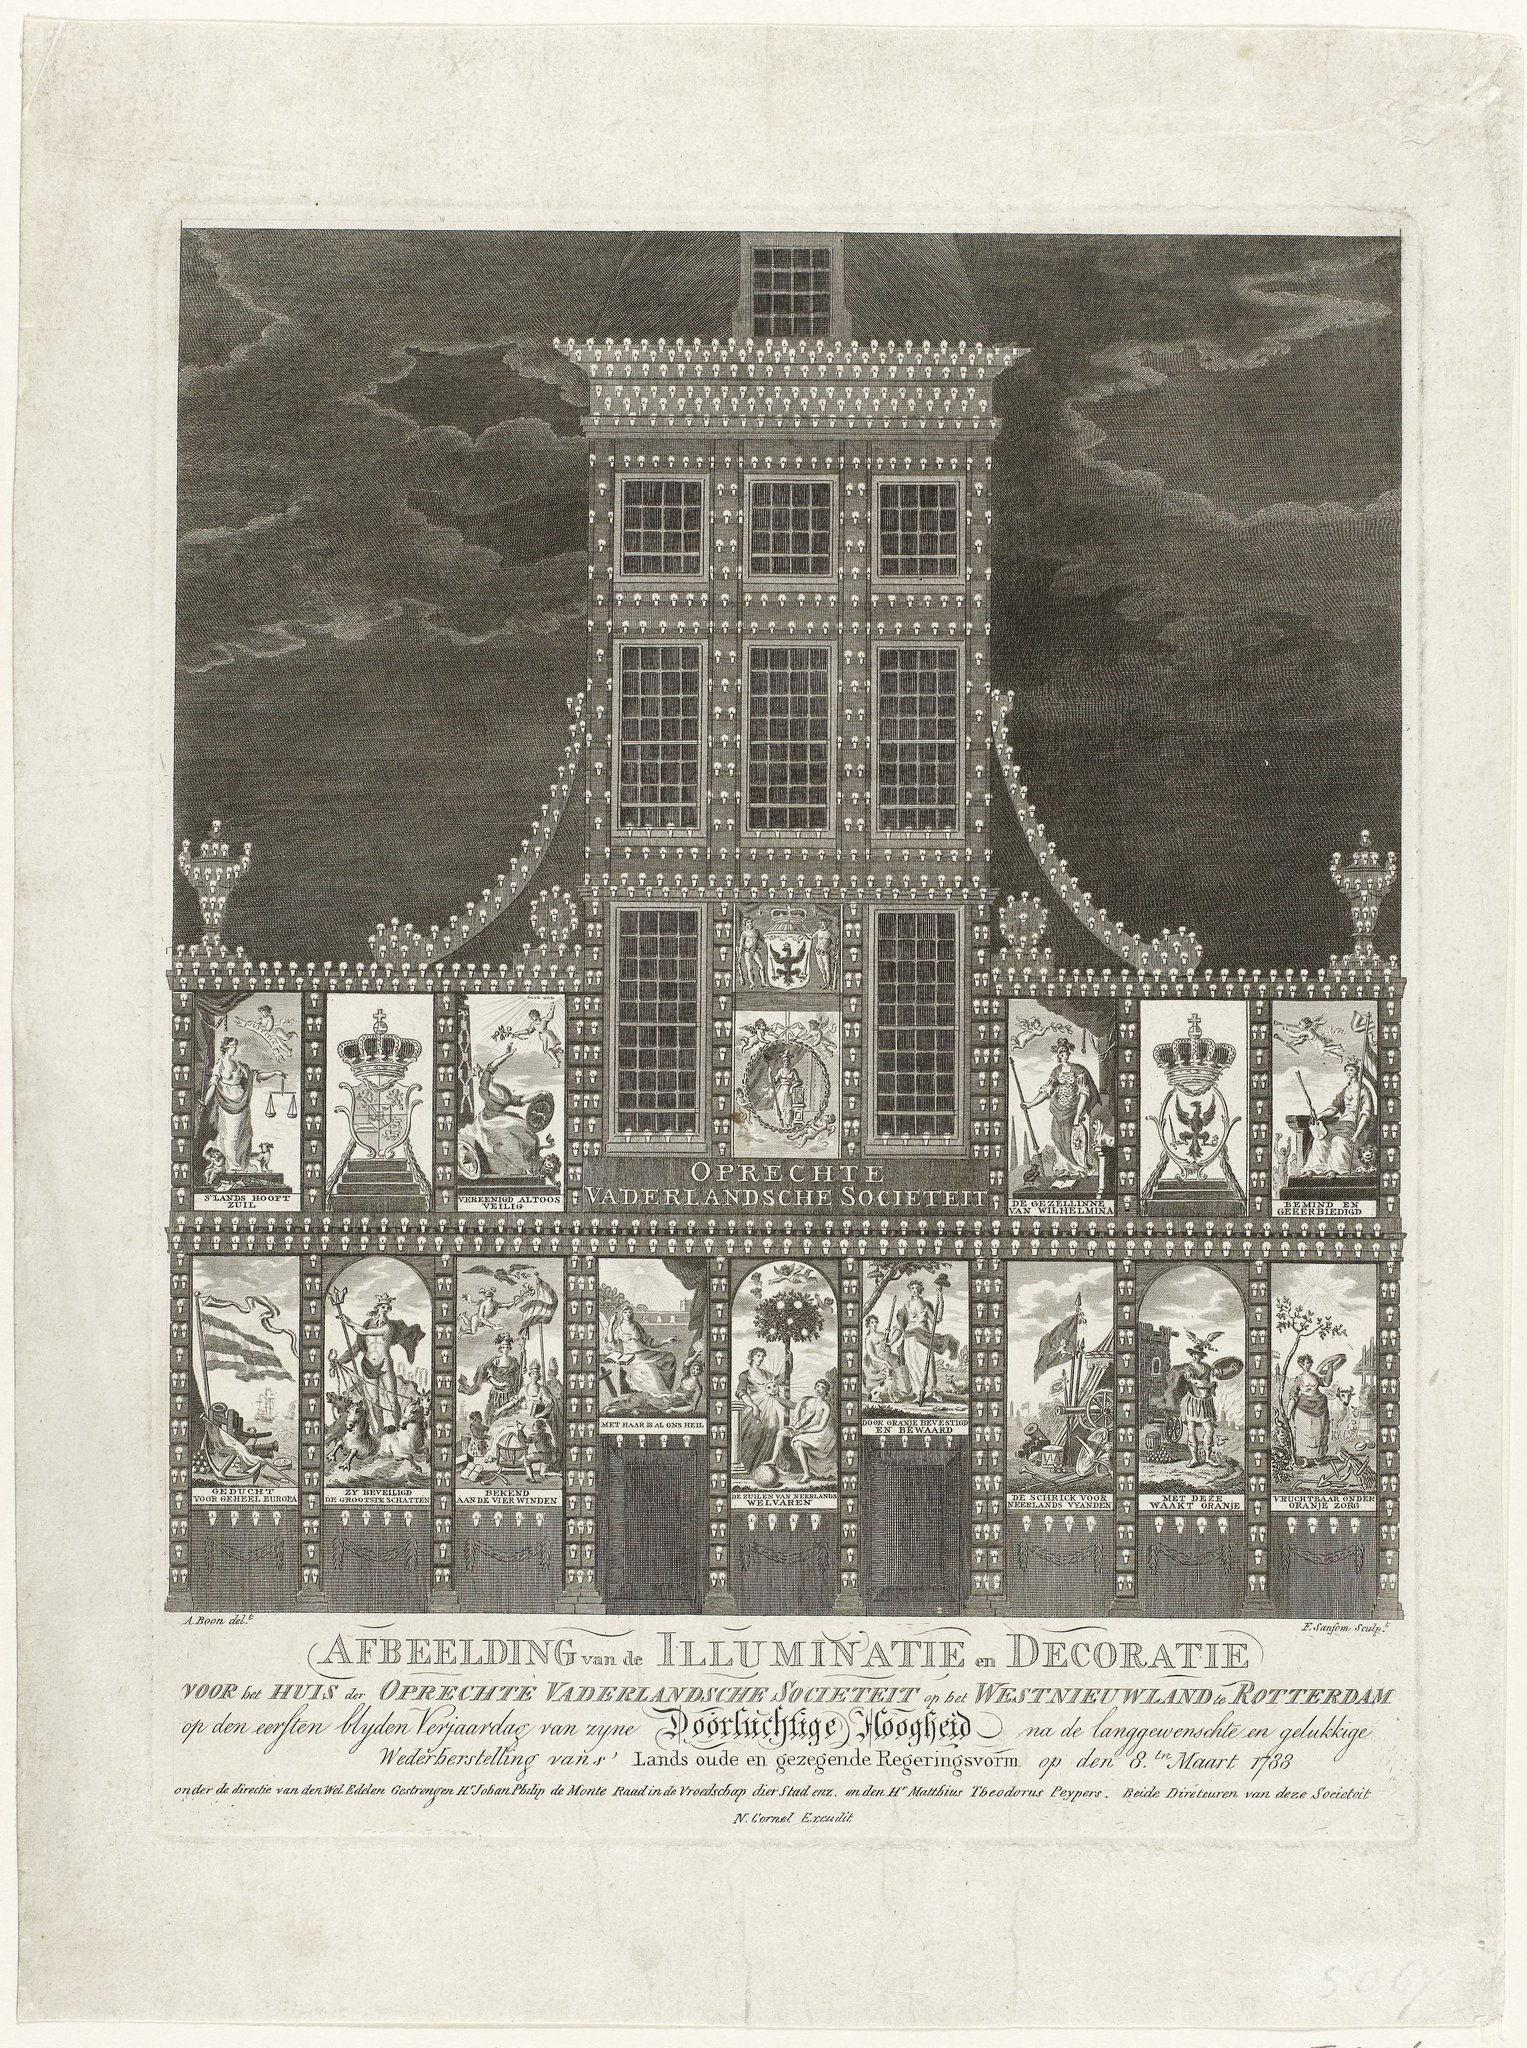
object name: print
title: Afbeelding van de Illuminatie en Decoratie voor het Huis der Oprechte Vaderlandsche Societeit op het Westnieuwland te Rotterdam (...) 8 Maart 1788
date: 1788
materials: paper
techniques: engraving, etching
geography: rotterdam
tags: william v (prince of orange), public festivities at other royal events, not meant or mentioned above (+ illumination, fire-works ~ festive activities), bonfire, fire-works (+ illumination, fire-works ~ festive activities), rotterdam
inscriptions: collector's mark: Lugt 2228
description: Illuminatie van de gevel van het pand van de Oprechte Vaderlandsche Sociëteit op het Westnieuwland te Rotterdam, ter gelegenheid van de veertigste verjaardag van prins Willem V op 8 maart 1788 en het herstel van de oude constitutie. De gevel versierd met lichtjes en zestien chassinetten met allegorische voorstellingen (vóór de twee die pas later op 7 augustus zijn geplaatst).